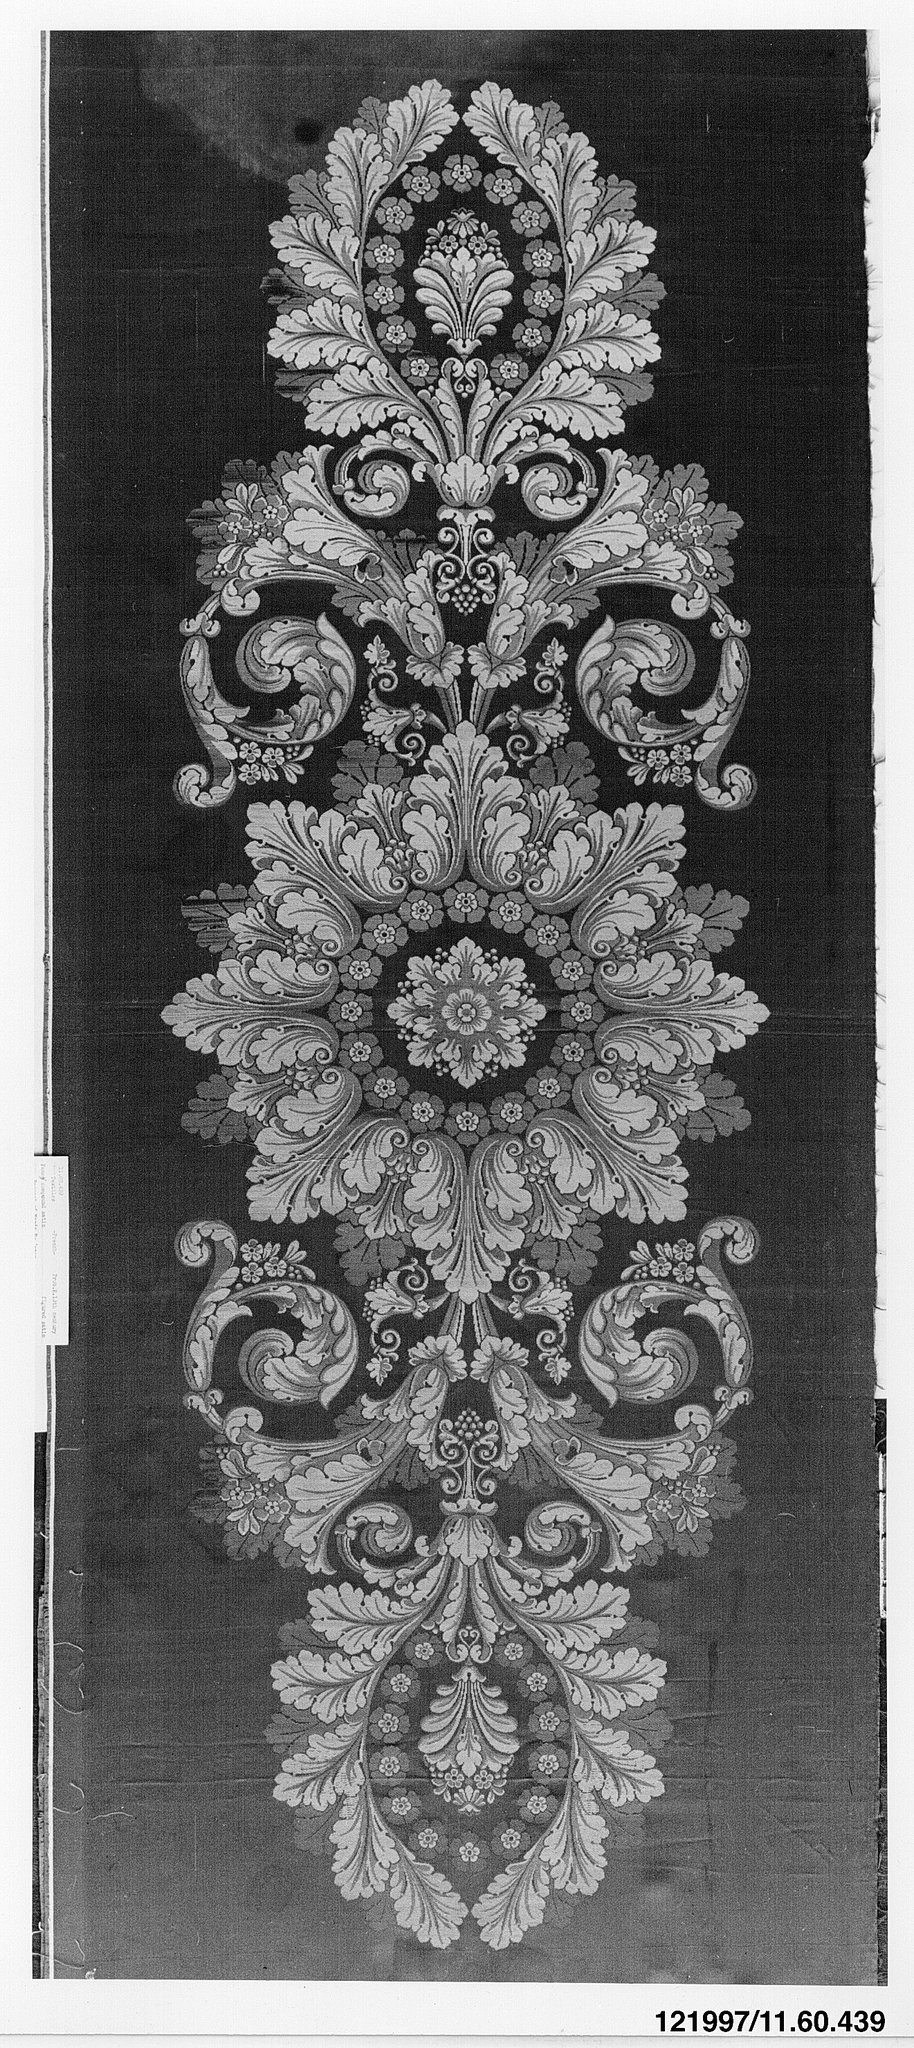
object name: piece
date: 1801-1833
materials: silk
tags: leaves